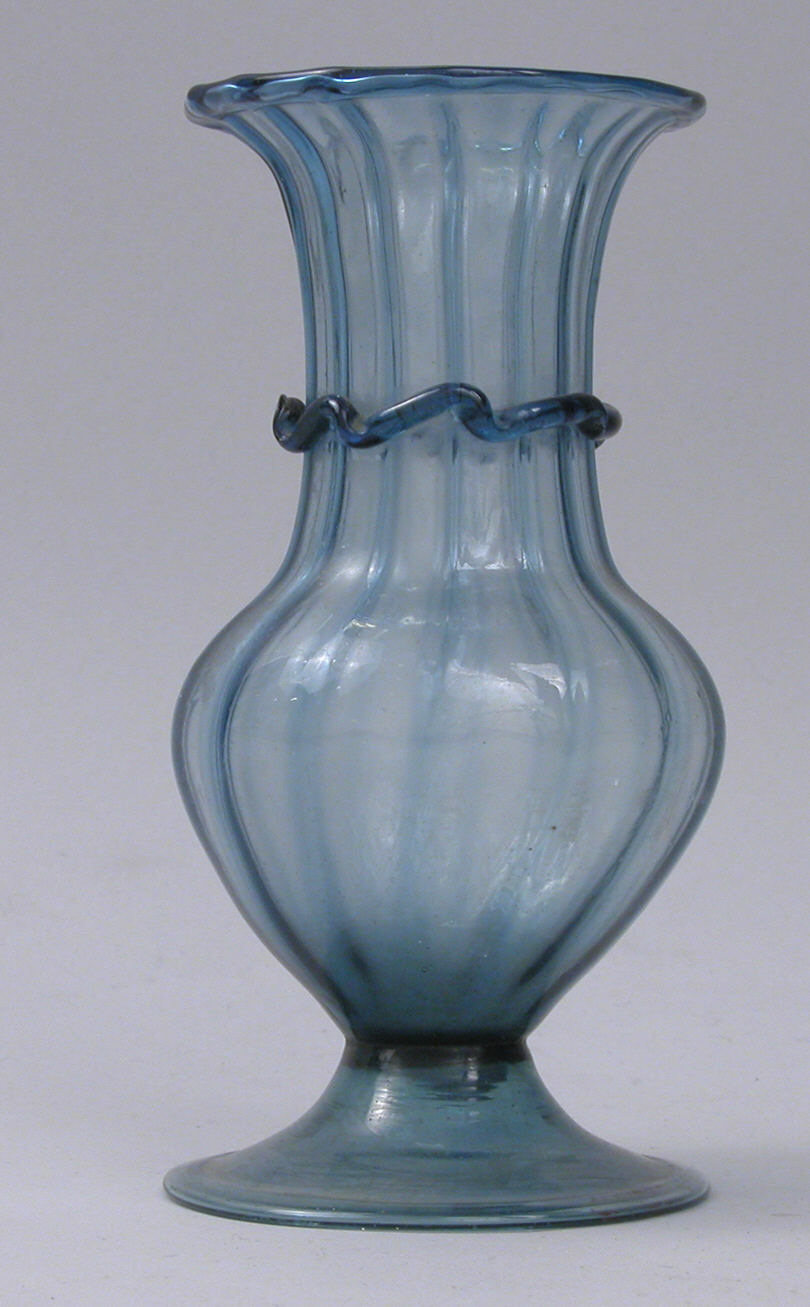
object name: vase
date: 1701-1900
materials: glass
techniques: glassblowing, tooling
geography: iran